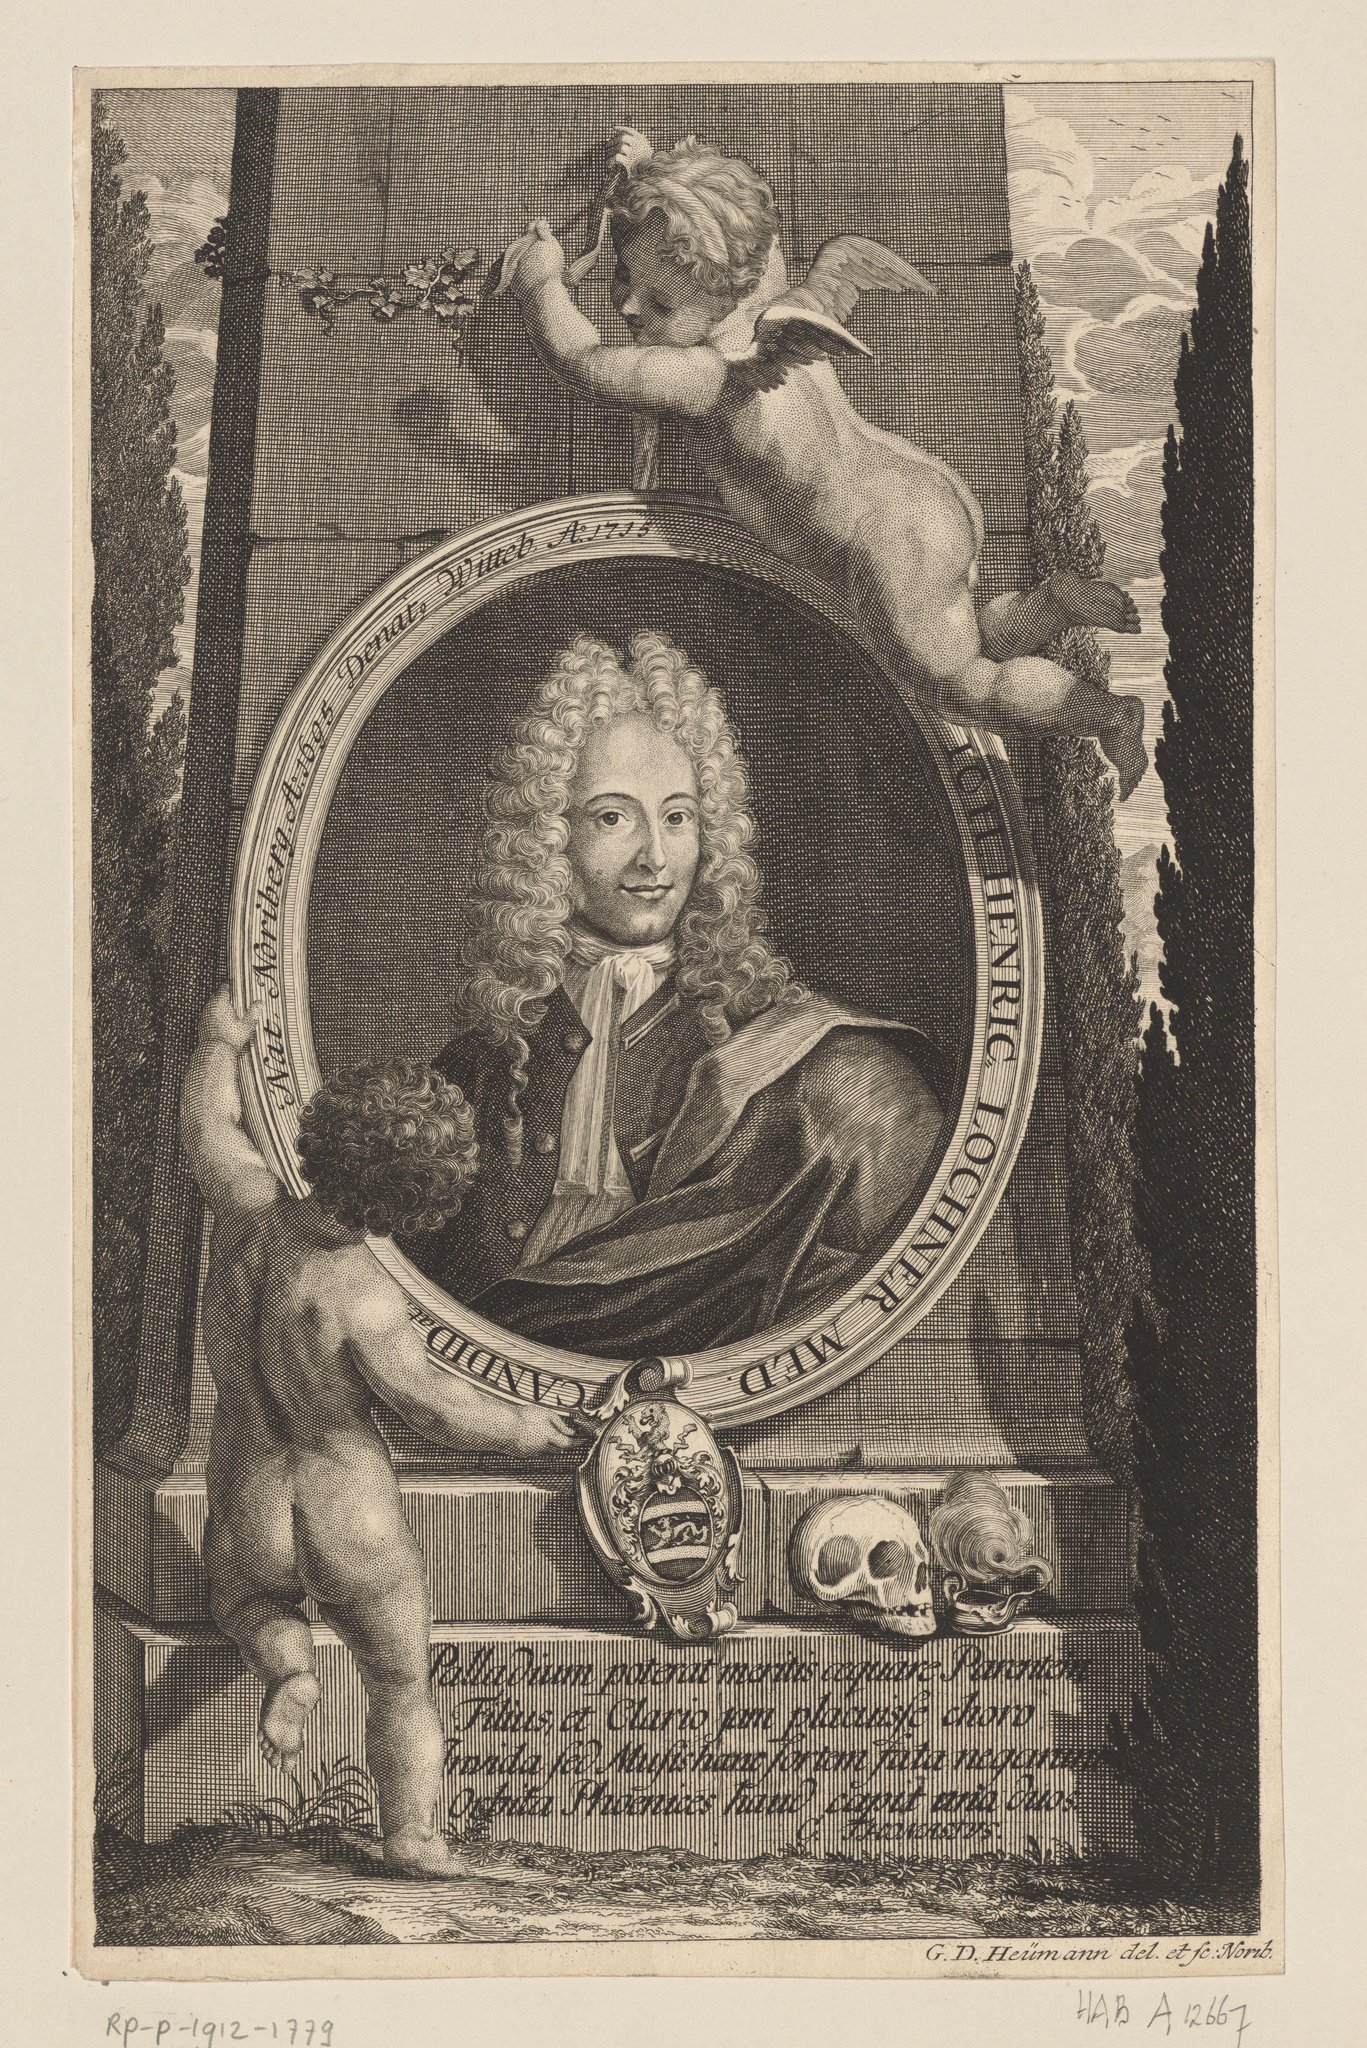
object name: print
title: Portret Johann Heinrich Lochner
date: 1716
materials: paper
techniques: engraving, etching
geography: nuremberg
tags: ornament ~ medallion, historical persons, skull as symbol of 'vanitas', grave, tomb and other grave-forms and grave-markers, cupids: 'amores', 'amoretti', 'putti', armorial bearing, heraldry, smoking pot as symbol of 'vanitas'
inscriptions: collector's mark: Lugt 2228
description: Monument met twee putti die een medaillon met het portret van Lochner ophangen. Met vierregelig vers in het Latijn onder het portret.